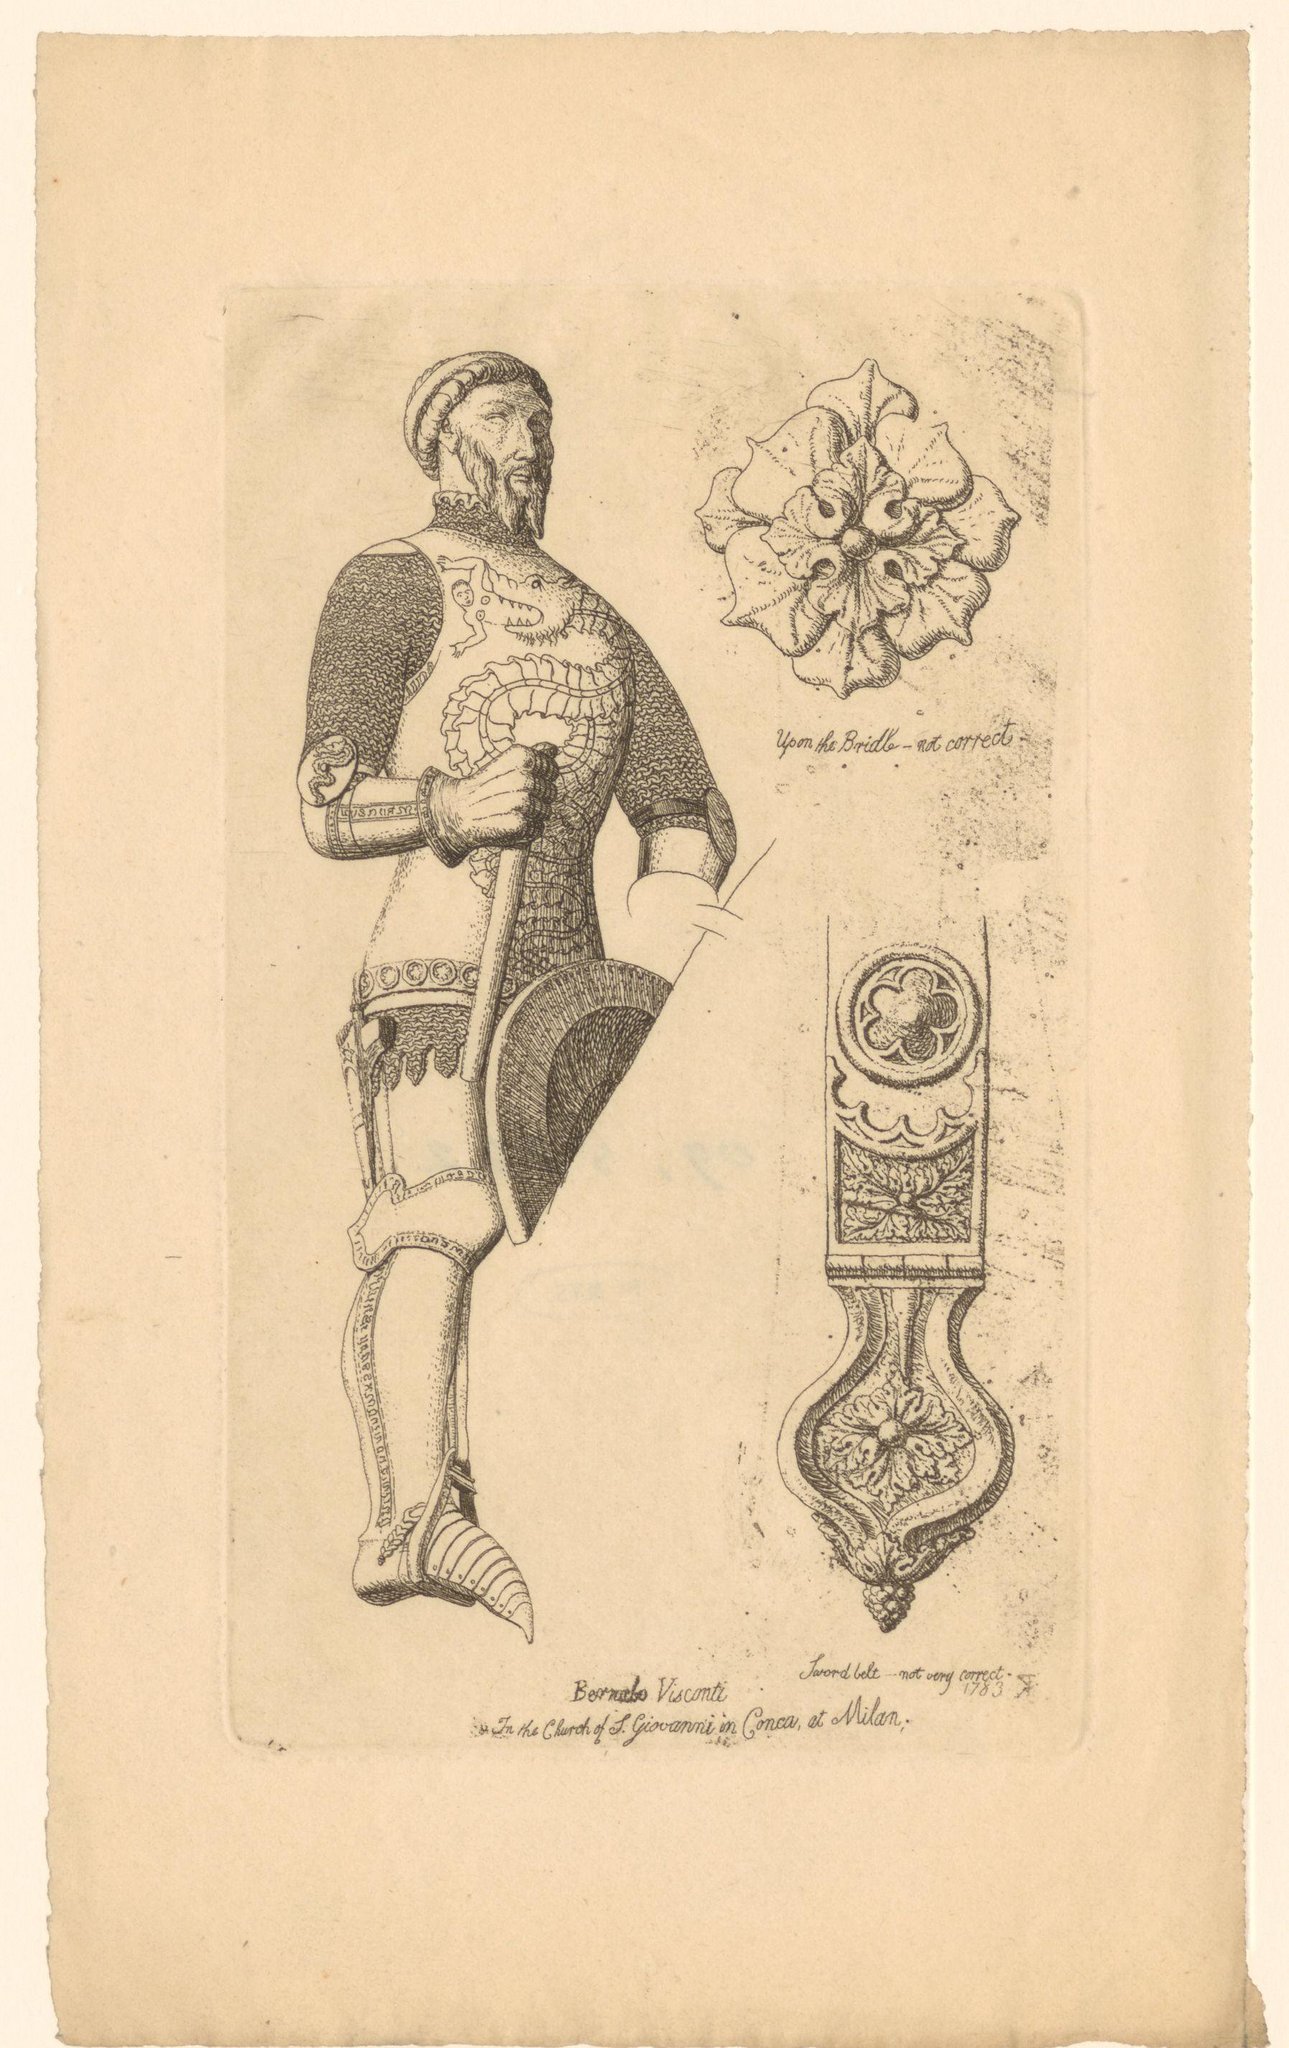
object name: print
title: Details van het praalgraf van Bernabò Visconti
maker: thomas kerrich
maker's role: draughtsman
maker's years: 1748-1828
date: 1783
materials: paper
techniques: etching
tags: historical persons, grave, tomb, sculpture, knight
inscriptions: collector's mark: Lugt 2228